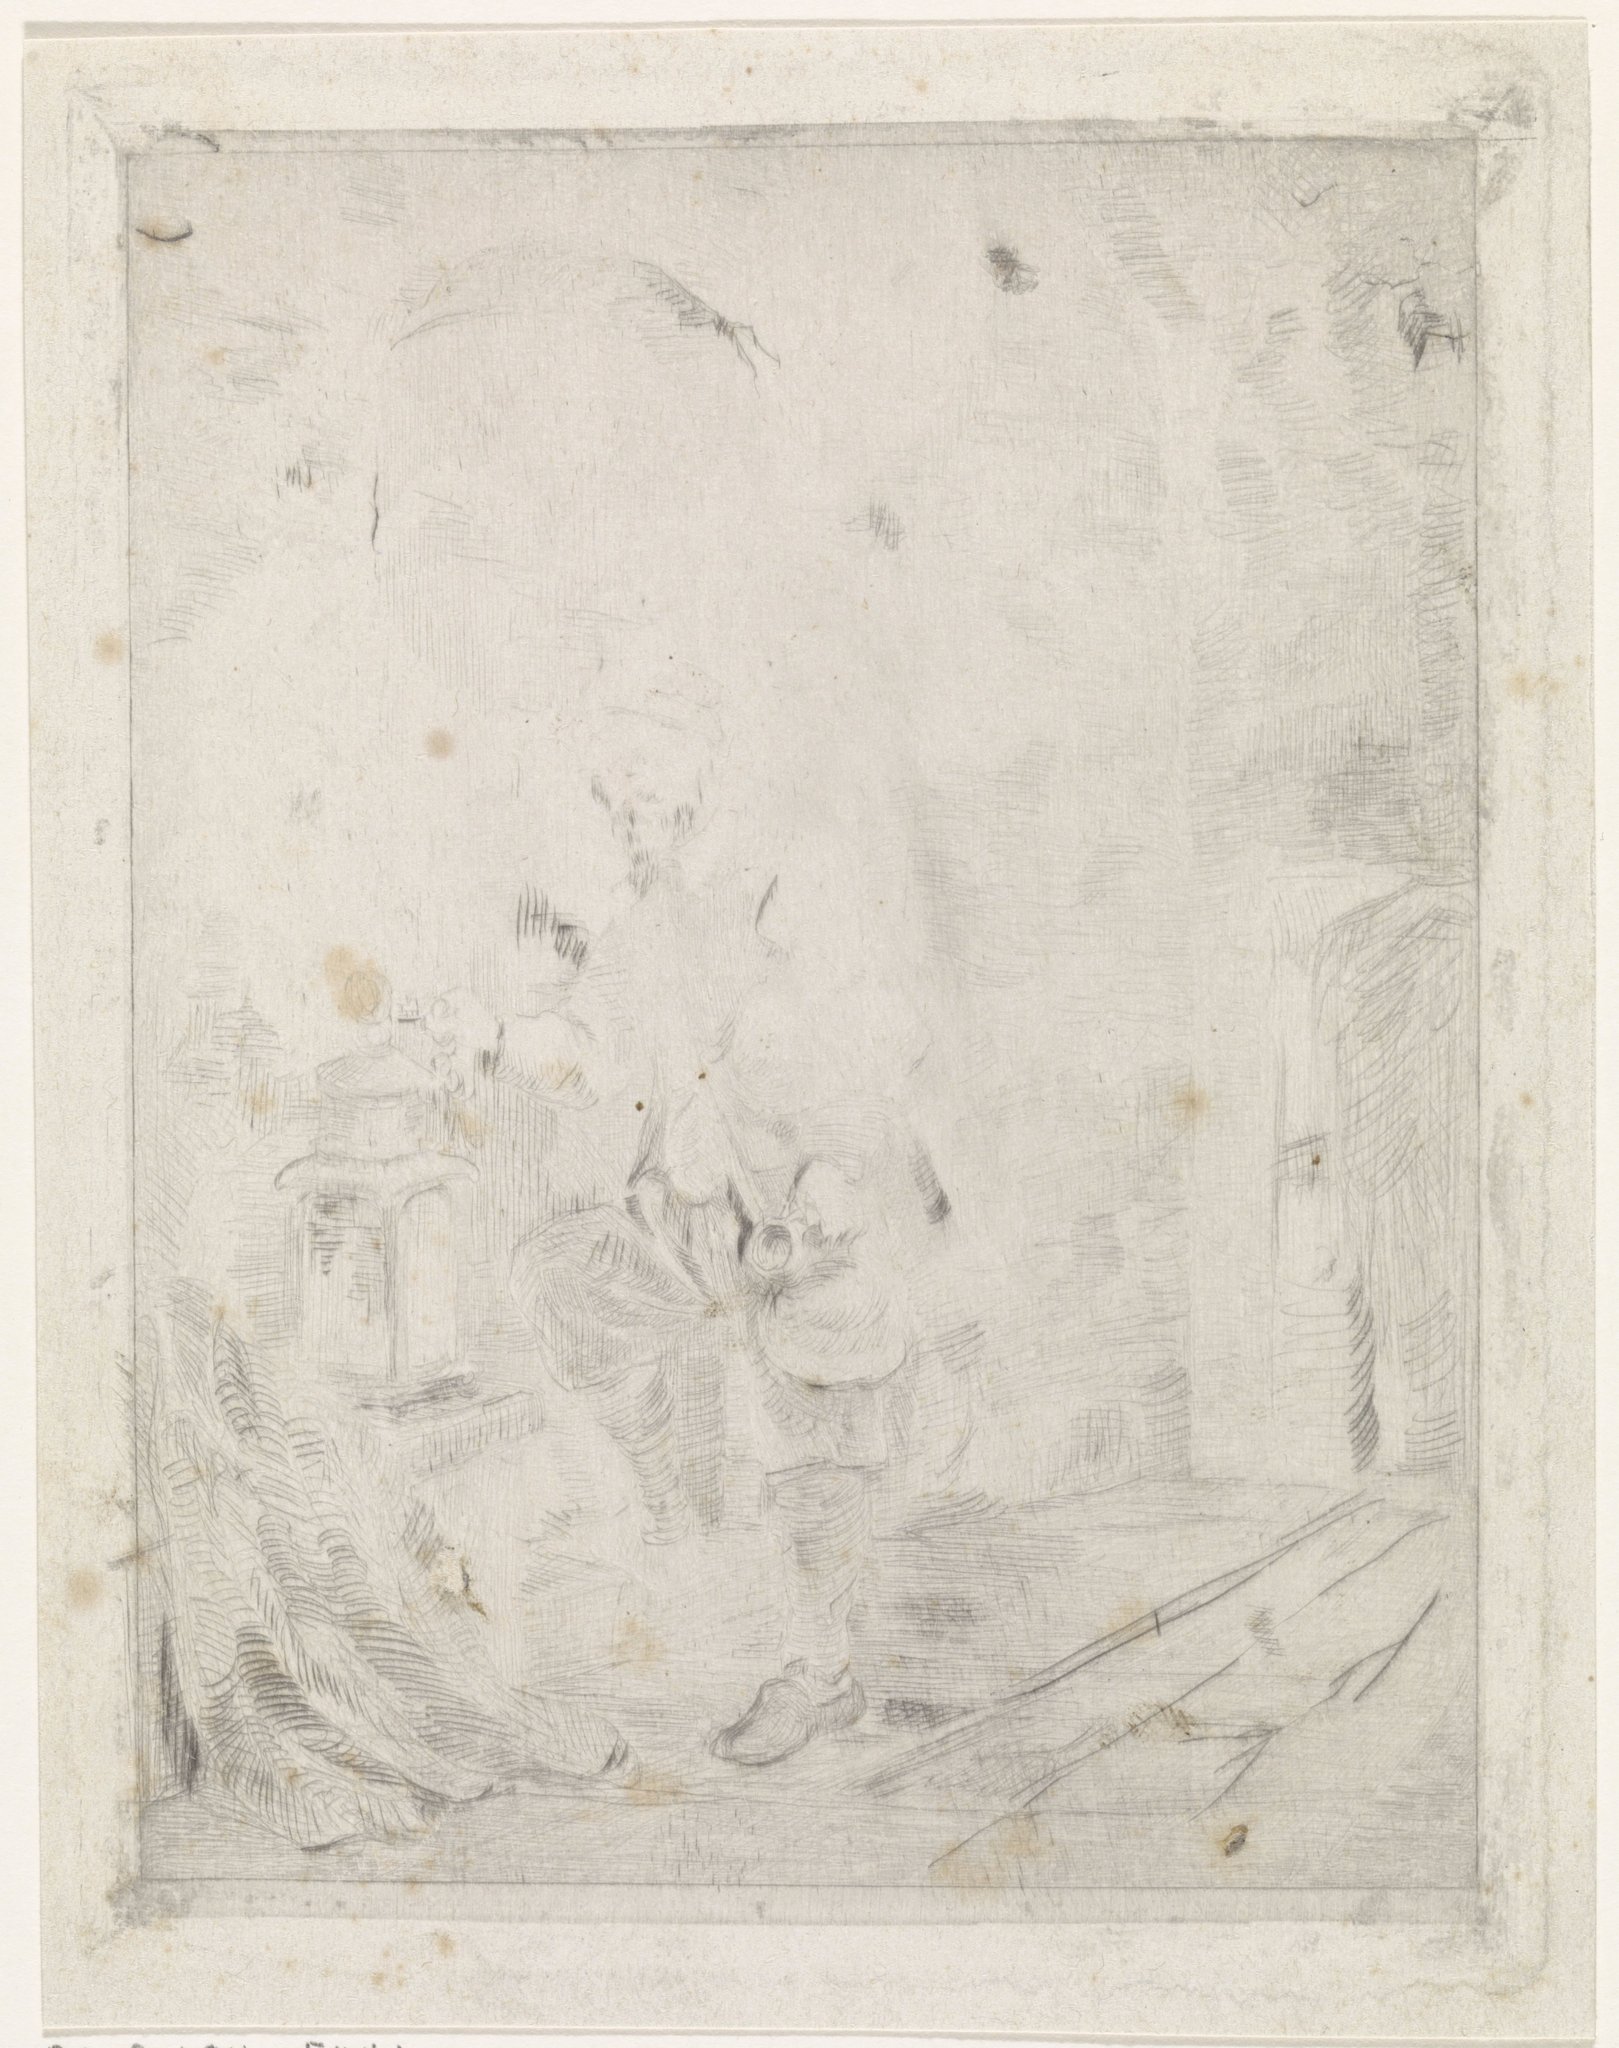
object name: print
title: Cipier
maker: david van der kellen (1827-1895)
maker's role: draughtsman, print maker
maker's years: 1827-1895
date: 1837-1882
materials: paper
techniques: etching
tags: prison, jail, prison personnel: jailers, warders, guards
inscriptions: collector's mark: Lugt 1485, collector's mark: Lugt 2228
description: In een vertrek van een gevangenis steekt een cipier een sleutel in het slot van de deur voor hem, terwijl hij zijn blik op de toeschouwer richt. De cipier heeft een kruik in zijn linkerhand en een brood onder zijn arm, naast de deur staat een lantaren.